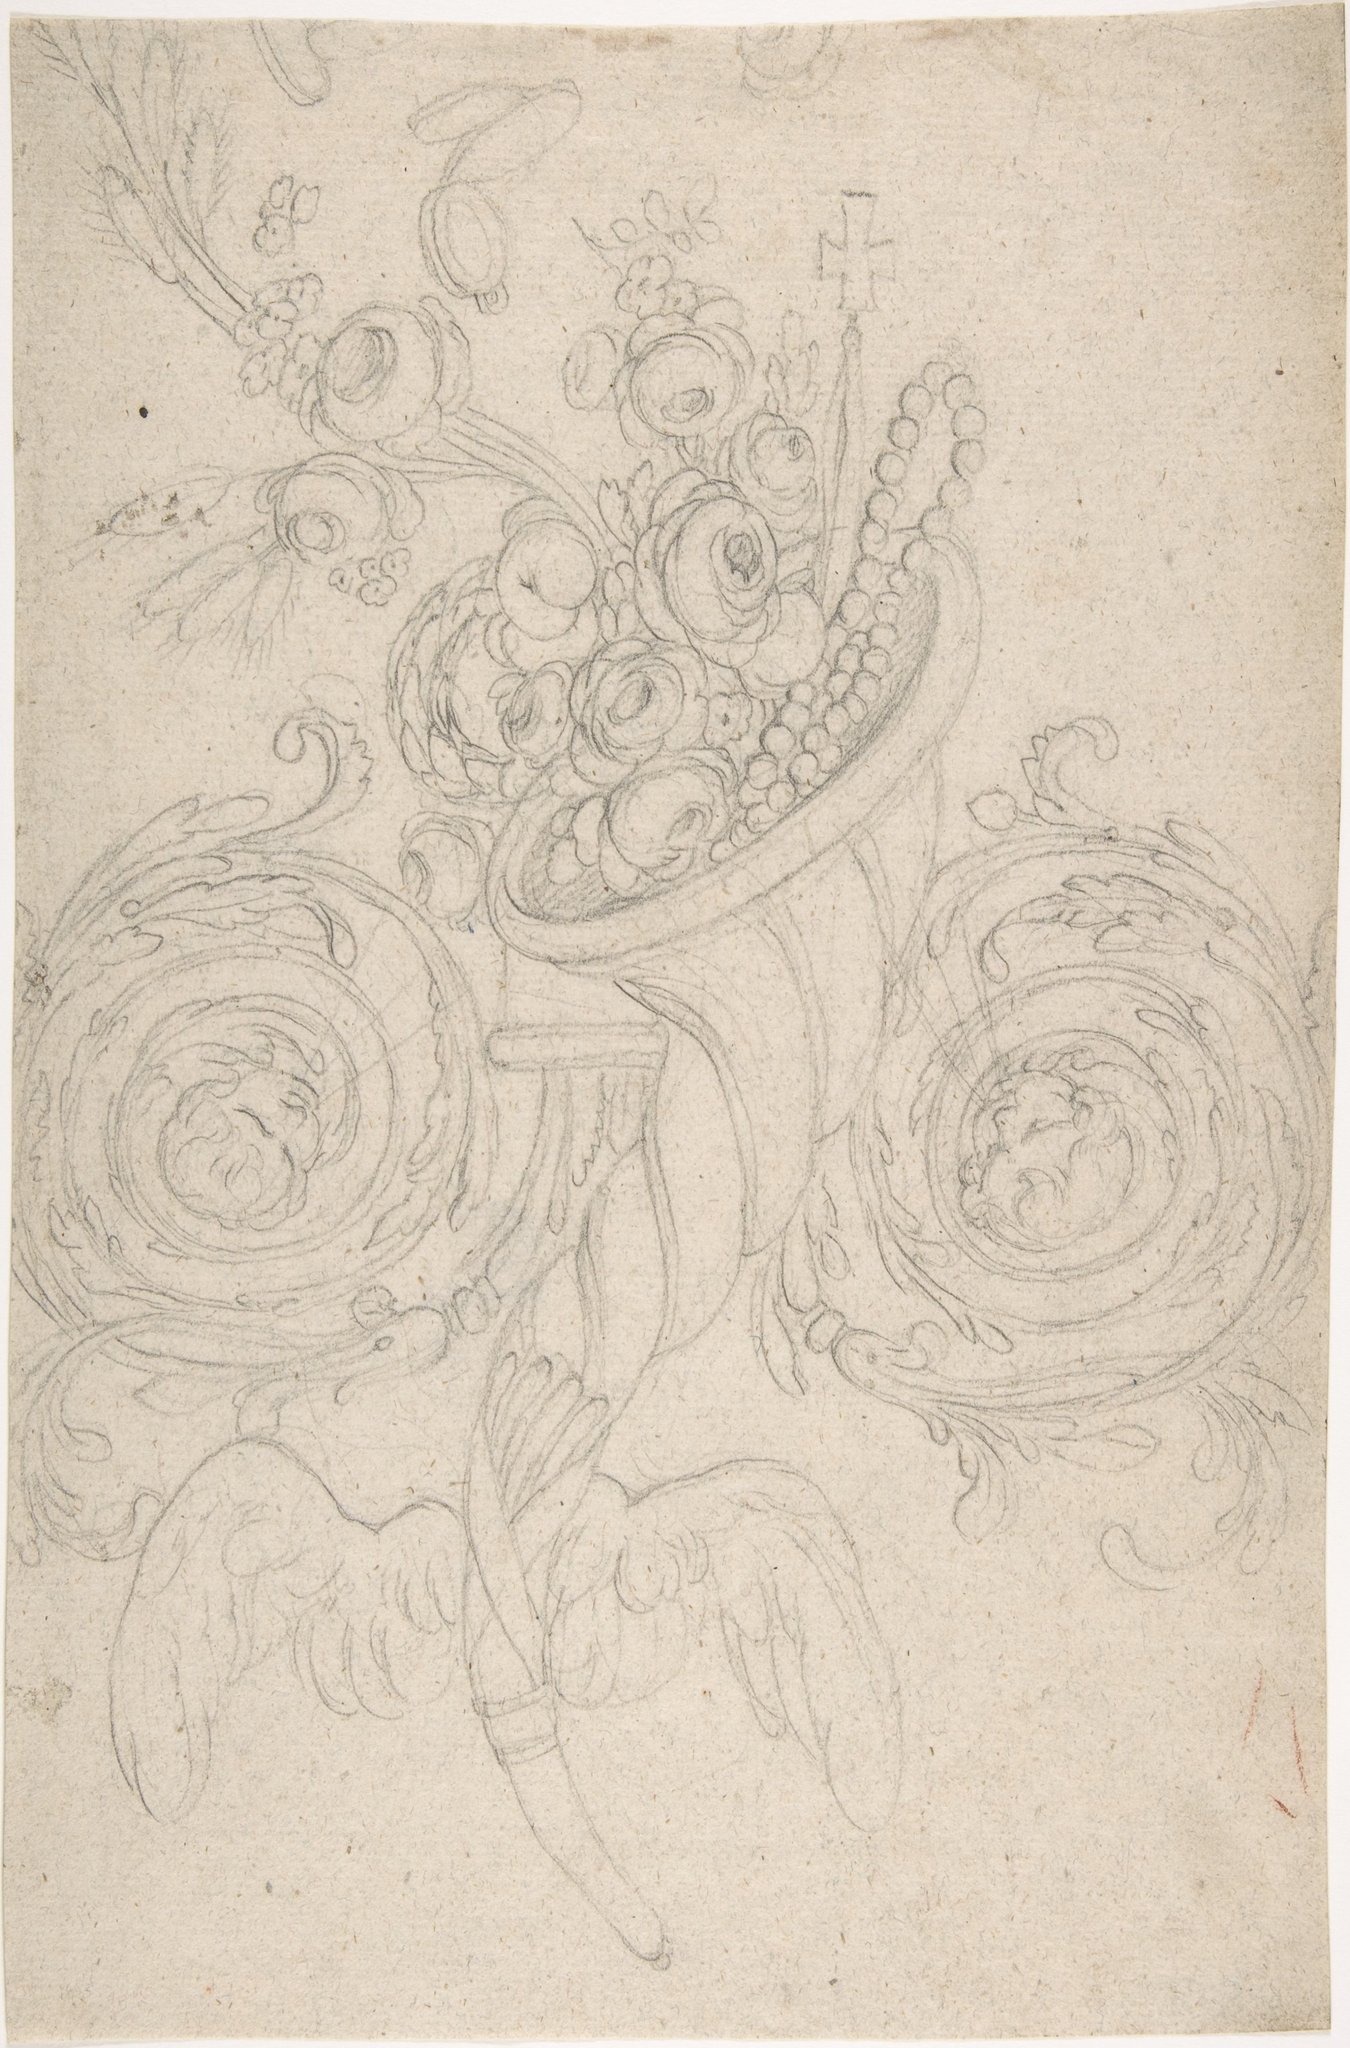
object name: drawing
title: Cornucopia Held Aloft by Angels, Ornament with Cross and Rosary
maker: anonymous, german, 19th century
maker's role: artist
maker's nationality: german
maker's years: 1800-1899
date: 1780-1820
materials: graphite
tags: ornament,cornucopia,flowers,rosaries